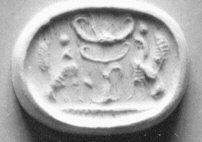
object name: stamp seal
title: Stamp seal (scarab) with monsters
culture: phoenician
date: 700-801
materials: stone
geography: cyprus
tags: griffins